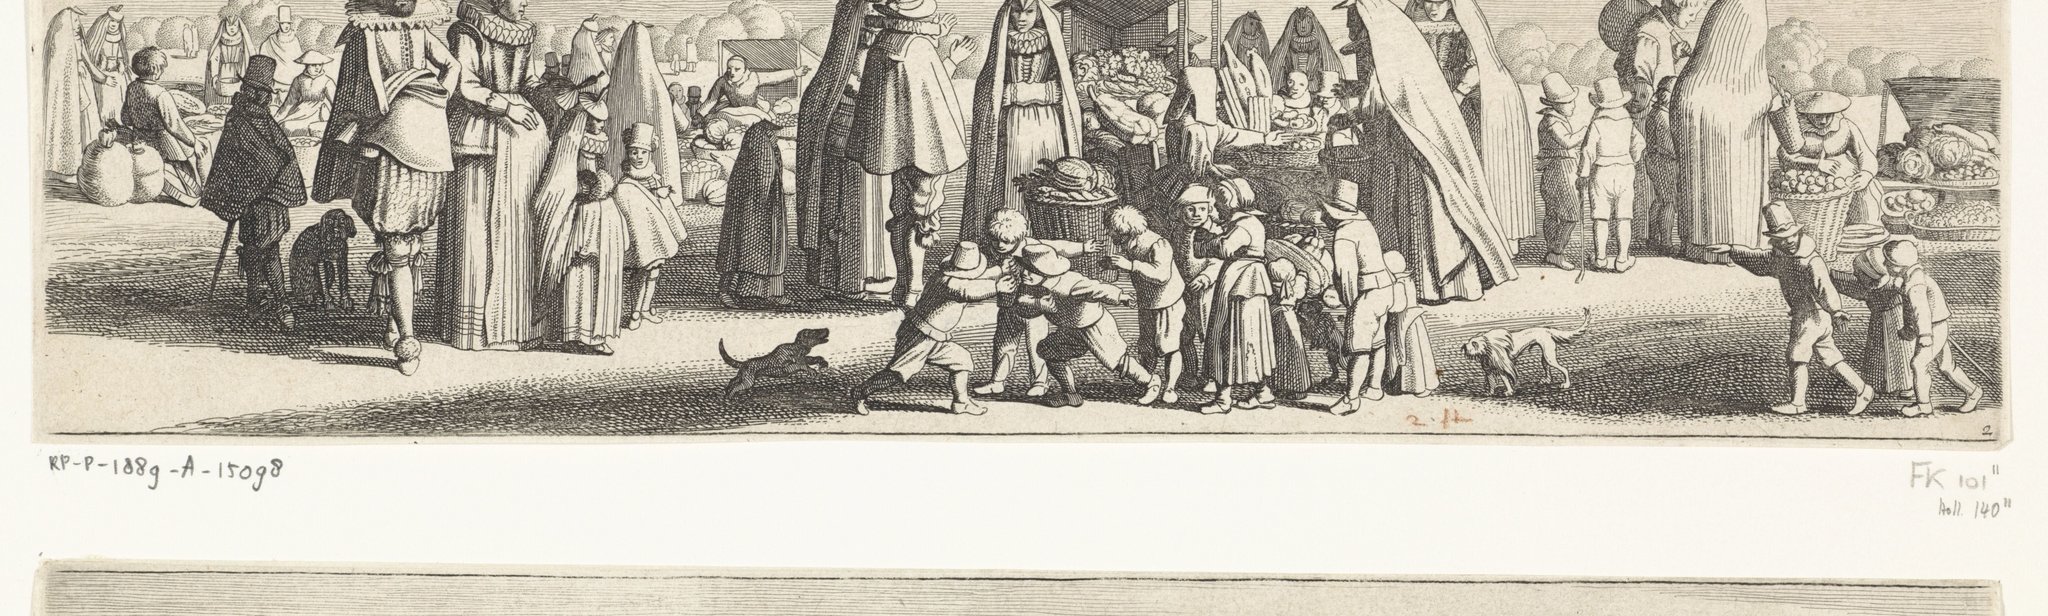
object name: print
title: Markt, serie A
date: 1603-1652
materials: paper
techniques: engraving, etching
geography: northern netherlands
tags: vegetables, cape (huik) (+ women's clothes), stall, booth (~ market), market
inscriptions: collector's mark: Lugt 2228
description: Elegant geklede dames en heren op een groentemarkt. Rechts een groentekraam waarvoor enkele dames, gekleed in huik. Links op de voorgrond een paar met kinderen. Op de voorgrond een groep kinderen. Tweede prent van een fries bestaande uit vier prenten, voorstellende een markt.